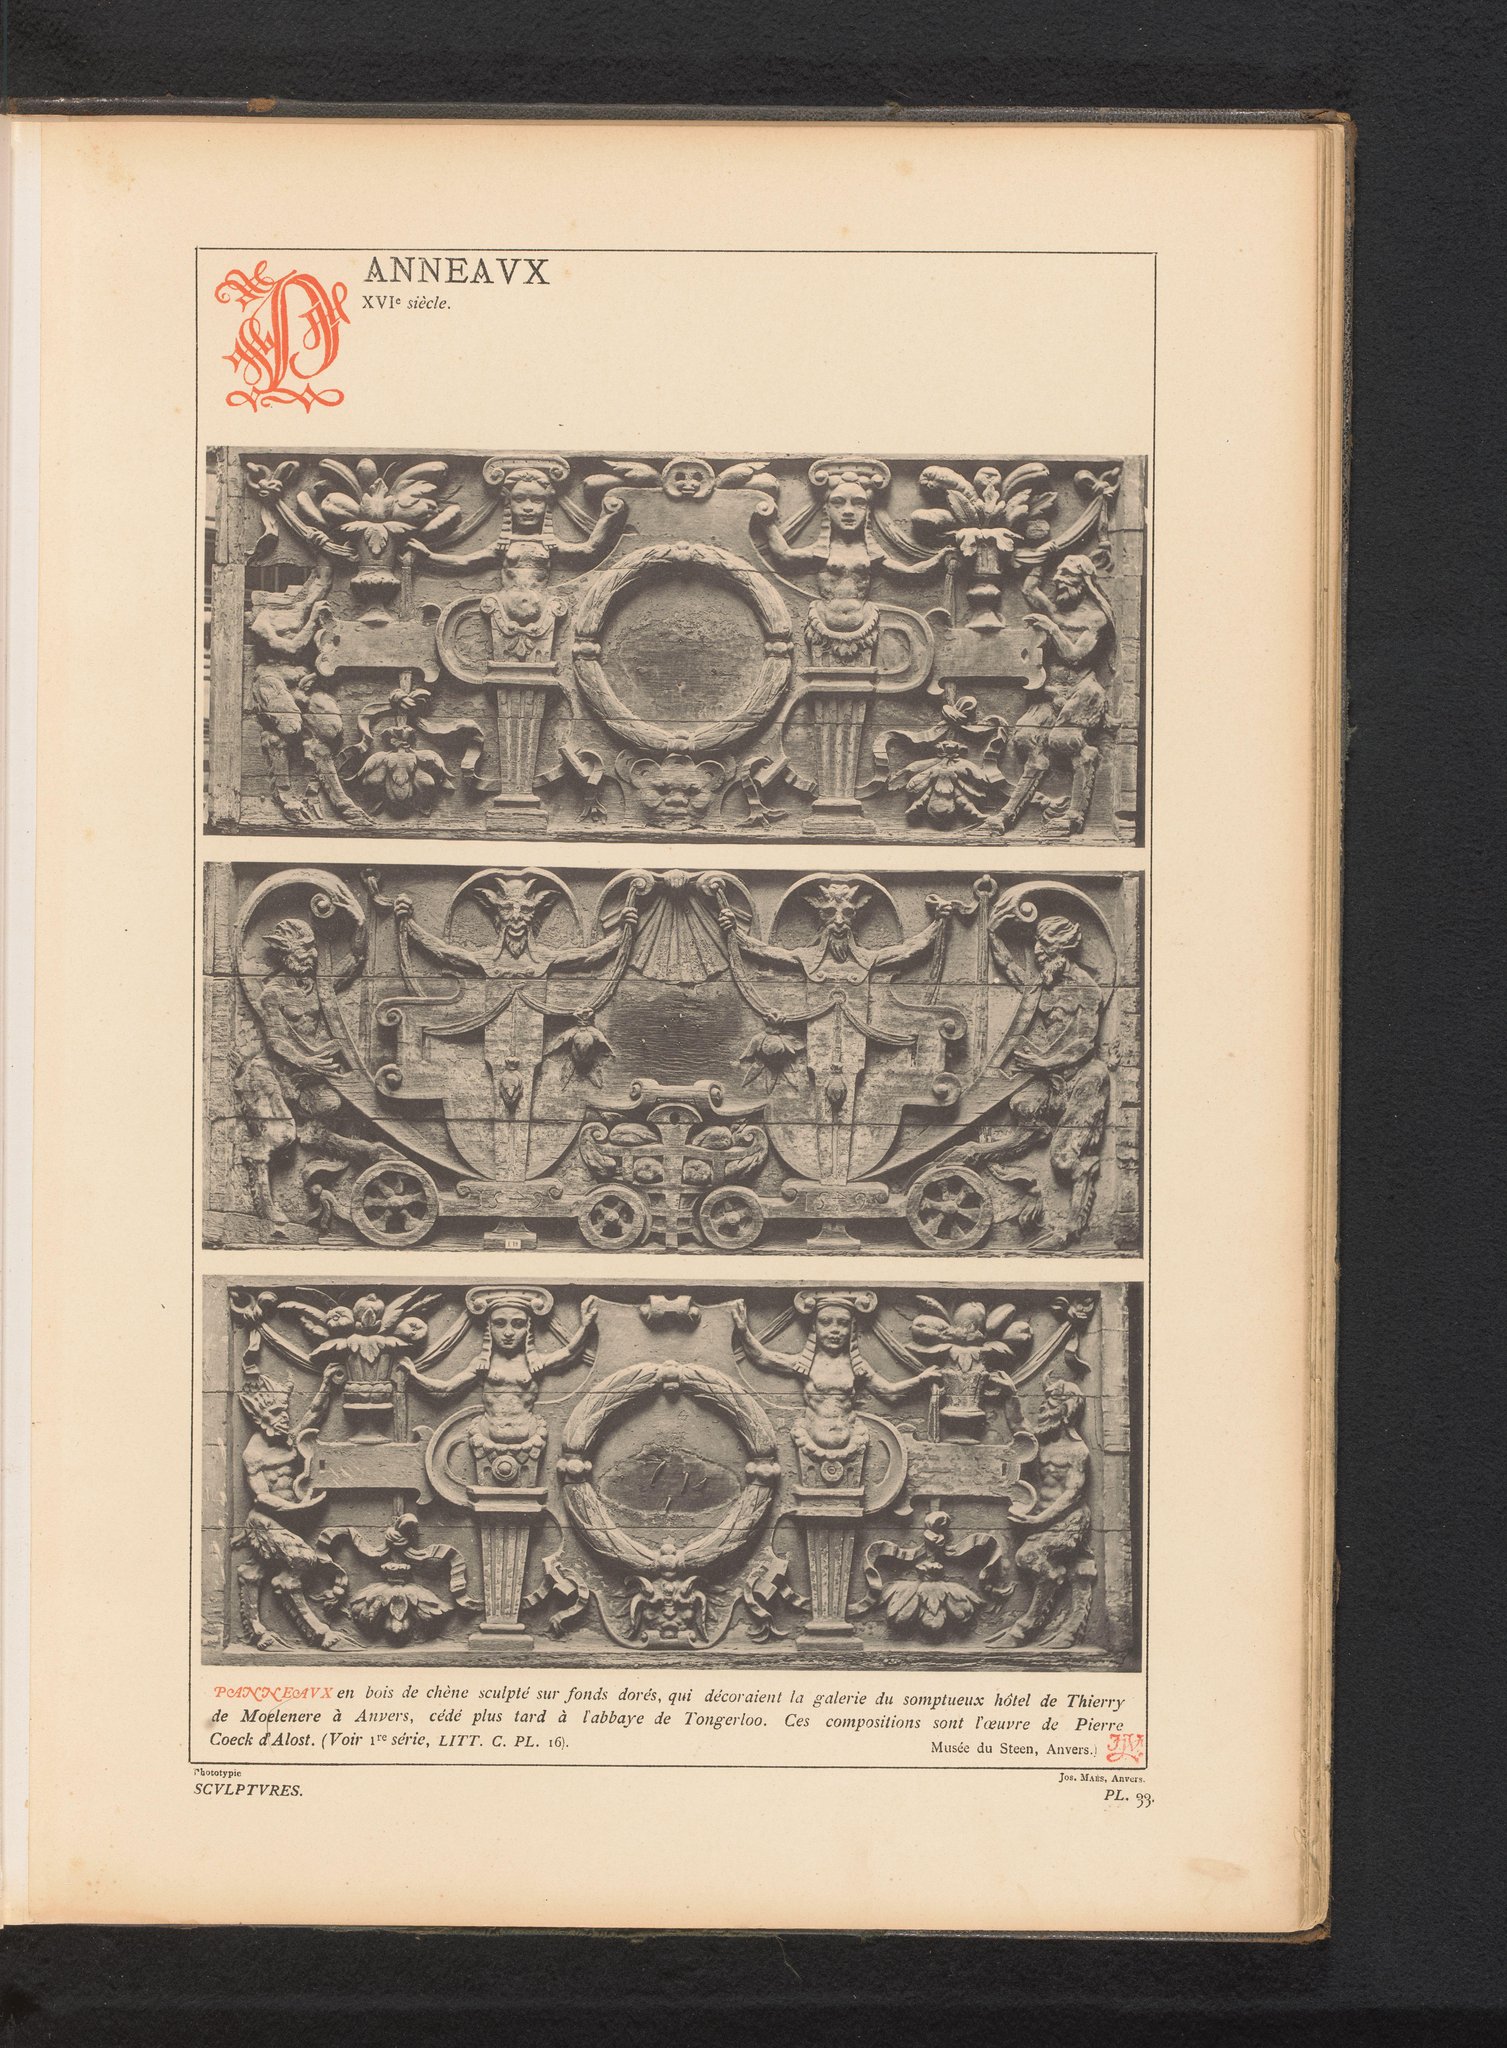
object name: page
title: Sculpture, XVe Siècle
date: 1881-1889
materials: paper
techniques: photograph, photolithography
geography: antwerp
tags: sculpture, handicrafts ~ wood, timber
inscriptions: monogram: ‘JJvY’, inscription: ‘SCULPTURE en bois (...)’, inscription: ‘SCULPTURES. PL. 33.’